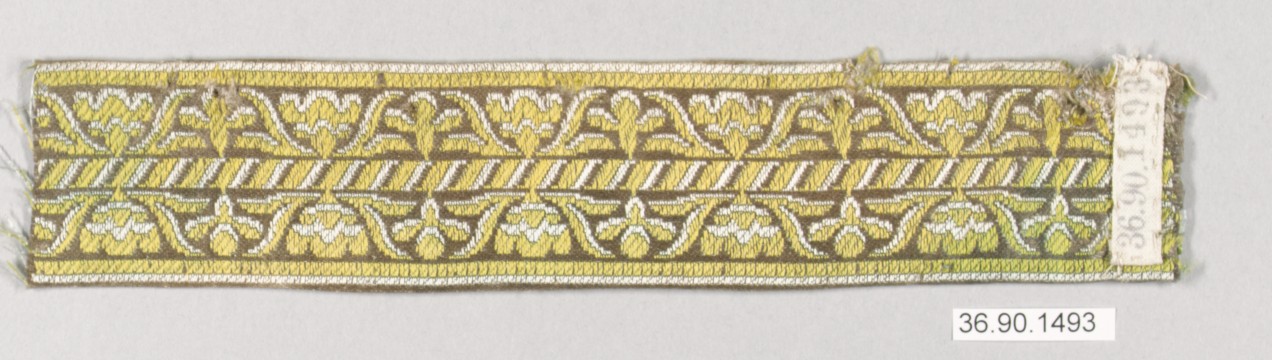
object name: ribbon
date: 1801-1900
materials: silk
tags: flowers